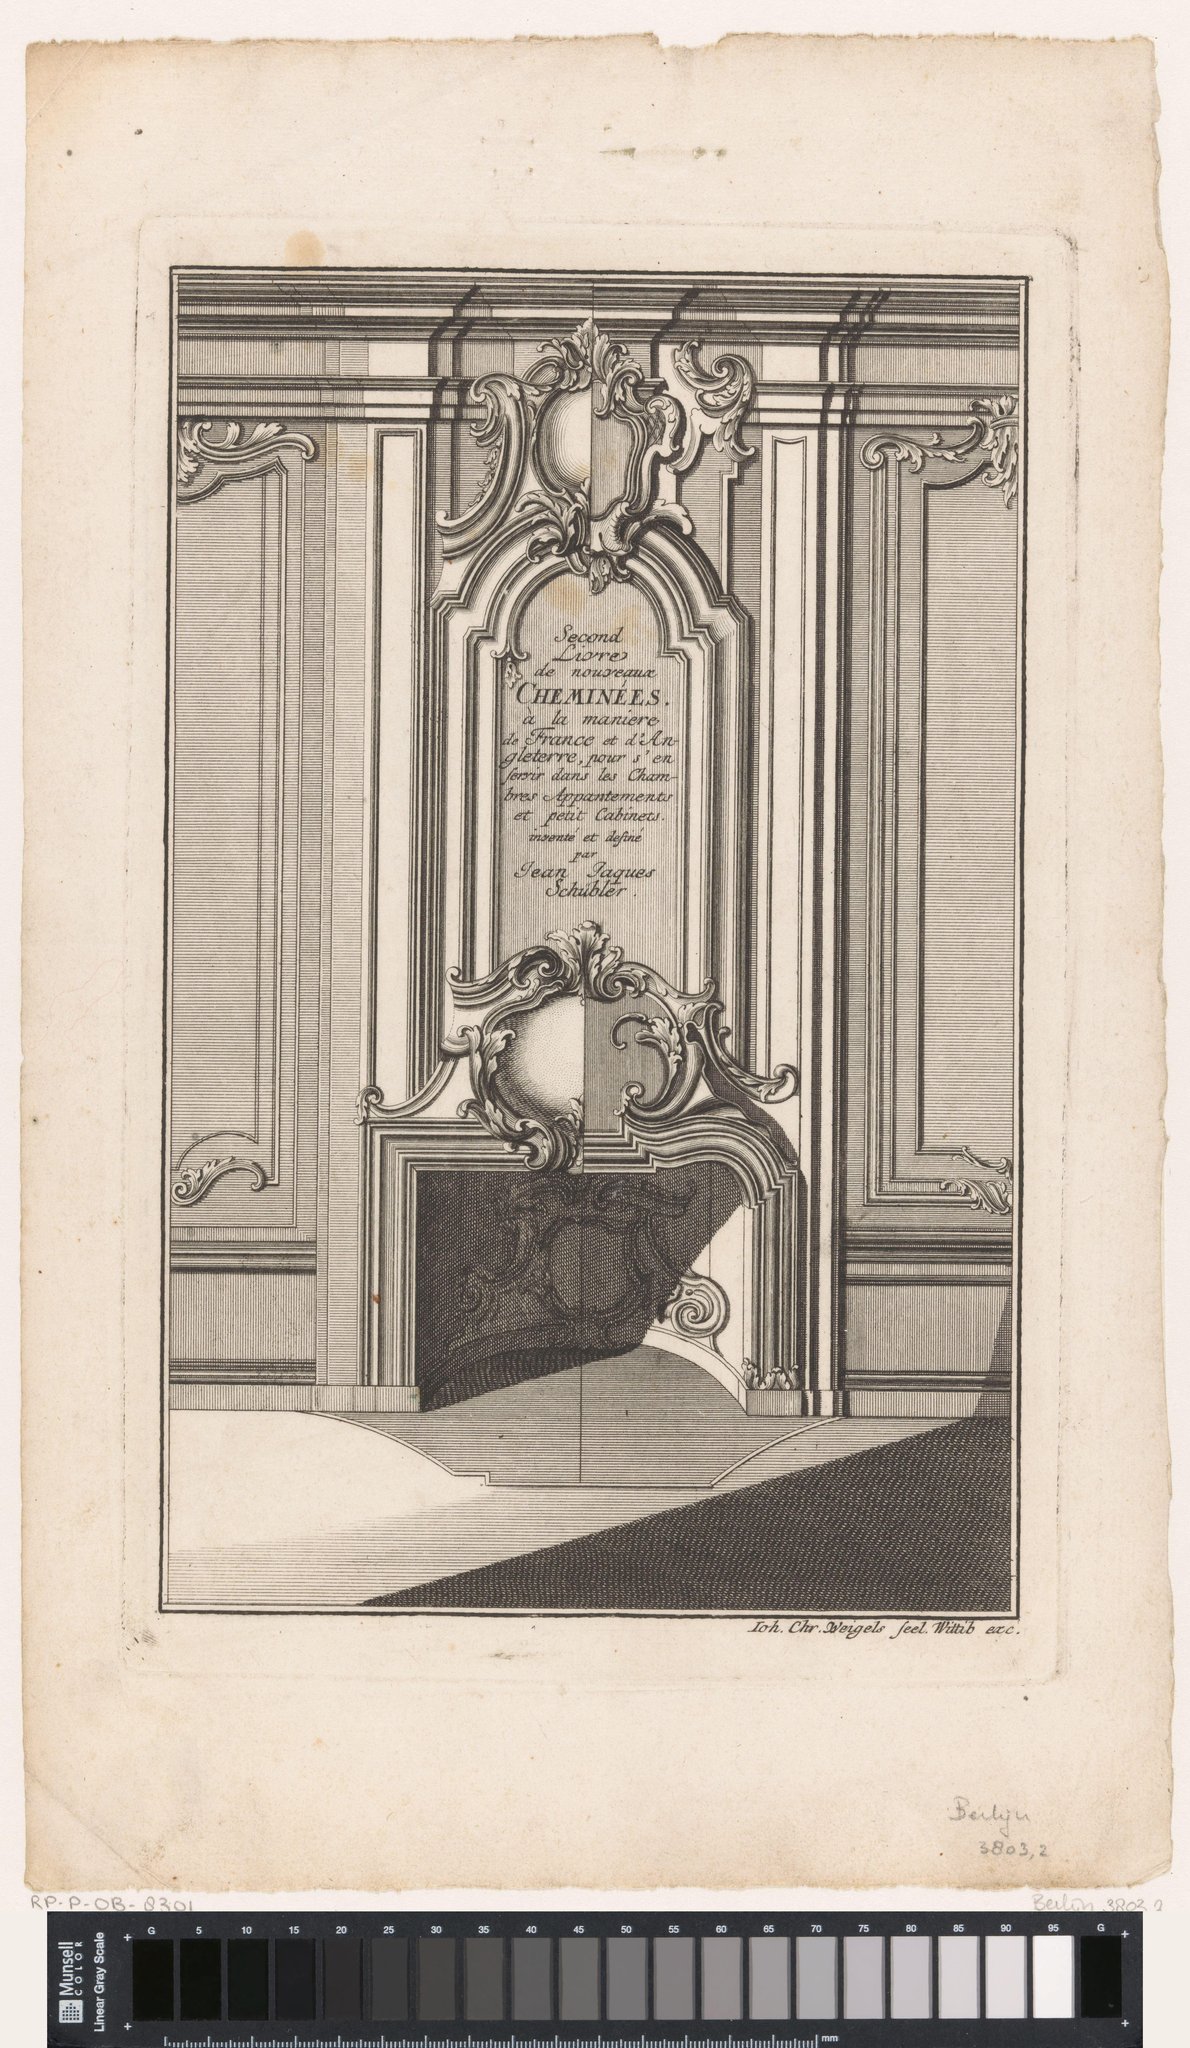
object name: titelprent, frontispice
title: Geornamenteerde schouw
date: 1726-1741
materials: paper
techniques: engraving, etching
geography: nuremberg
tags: rocaille ornament, open hearth, fire-place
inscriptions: collector's mark: Lugt 2228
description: Prent één uit een serie van zes, uit: Schübler, Johann Jakob. Second Livre de nouveaux Cheminées (...). [Neurenberg]: Weigel, weduwe Johann Christoph, [na 1726].